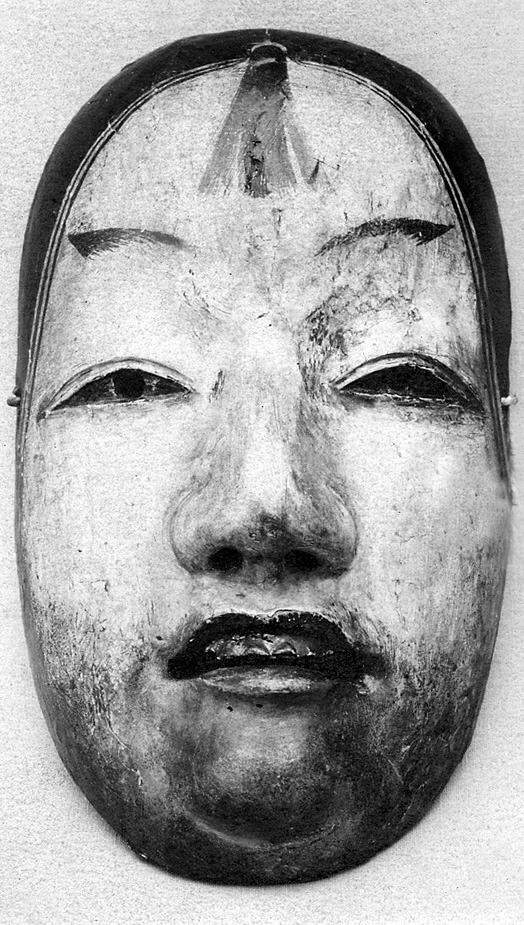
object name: noh mask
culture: japanese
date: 1336-1573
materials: wood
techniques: lacquer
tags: masks